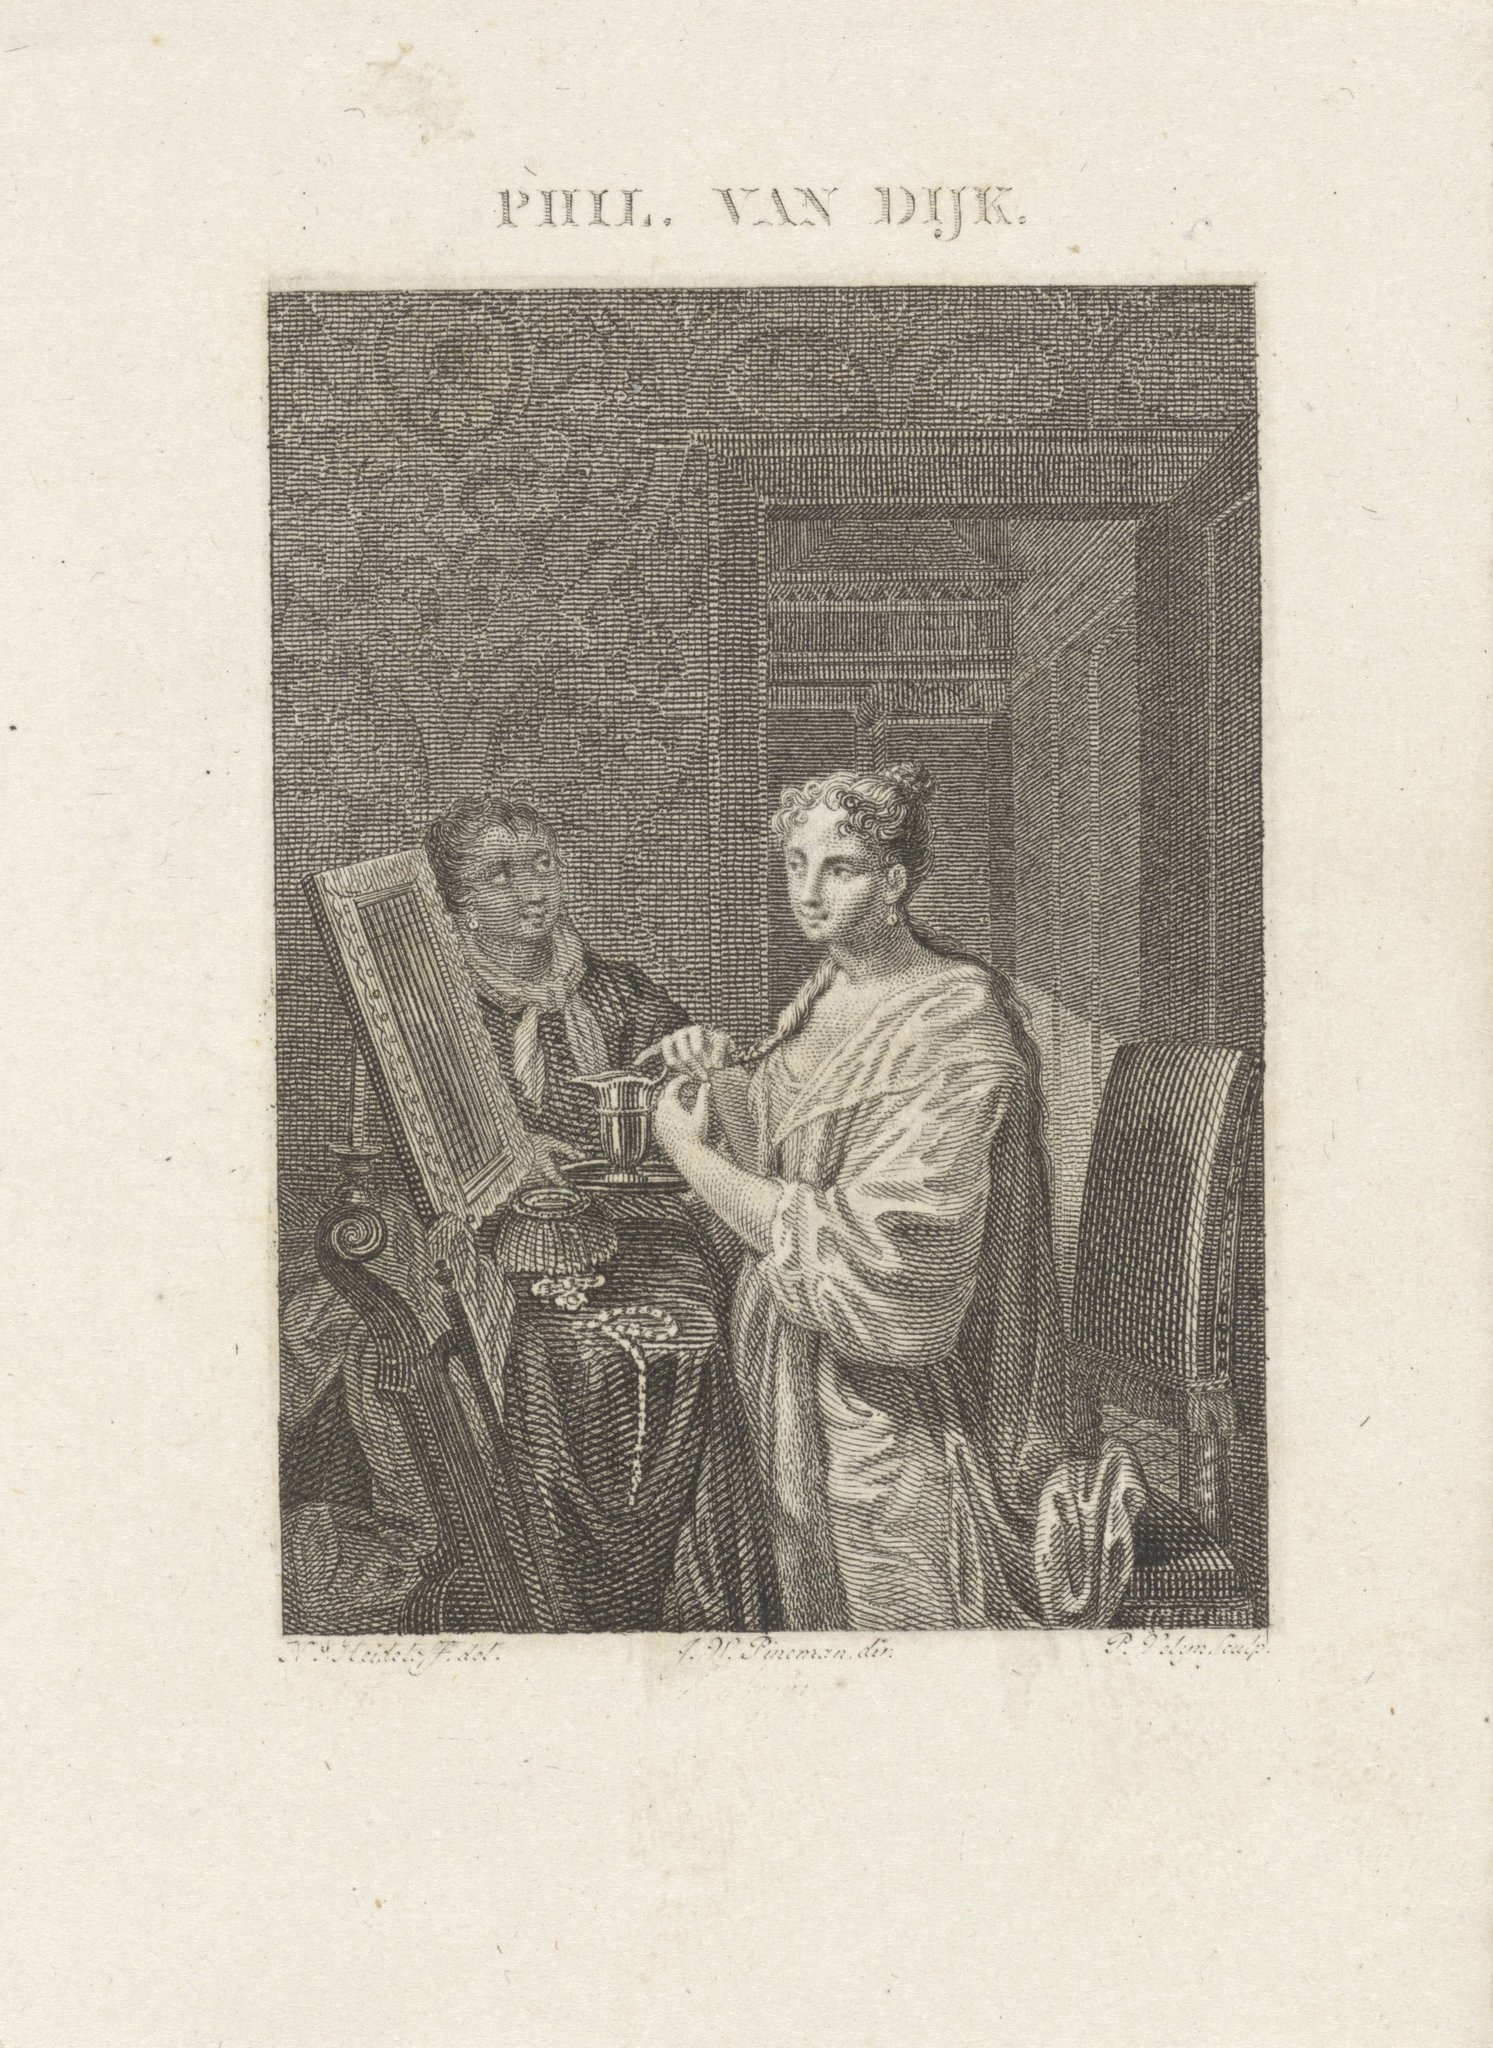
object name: print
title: Dame maakt haar toilet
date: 1819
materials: paper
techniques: engraving, etching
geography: netherlands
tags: maid ~ house personnel, making toilet - aa - (for) women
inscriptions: collector's mark: Lugt 2228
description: Een dame voor een spiegel maakt haar toilet. Naast haar een dienstmaagd met een dienblad.